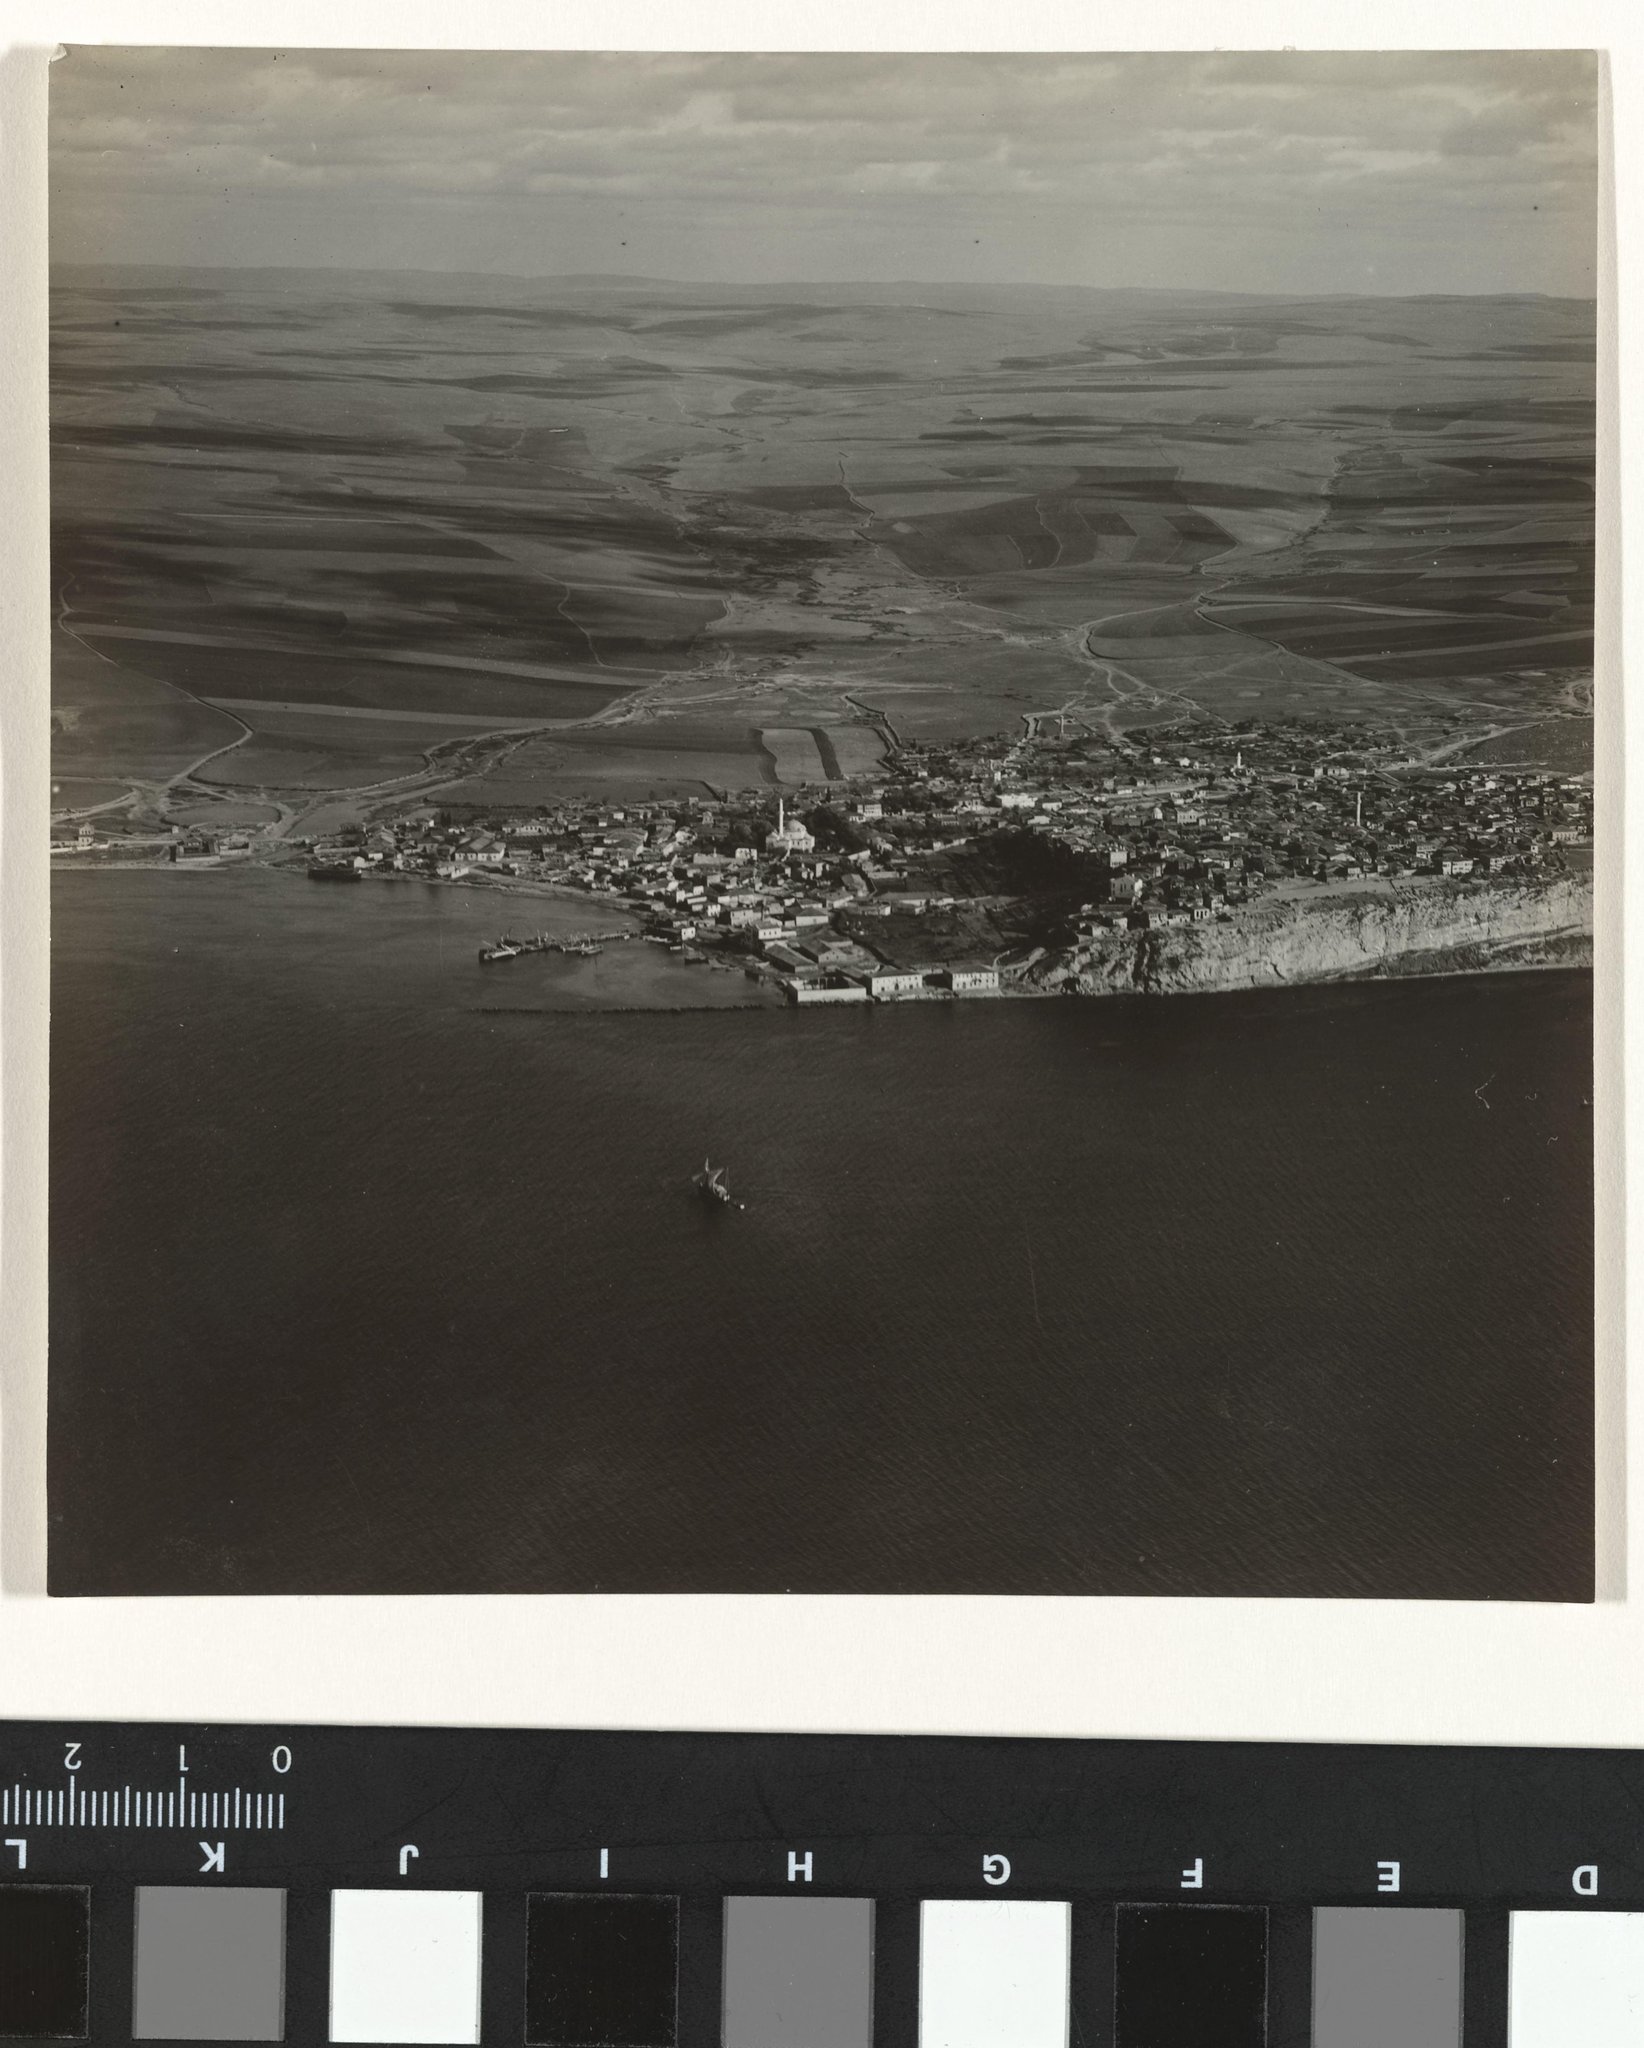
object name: photograph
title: Luchtfoto in zwart-wit van een stad of dorp omringd door weilanden, gelegen aan het water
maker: Anonymous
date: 1930-1975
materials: photographic support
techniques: gelatin silver print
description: Luchtfoto in zwart-wit van een stad of dorp omringd door weilanden, gelegen aan het water.